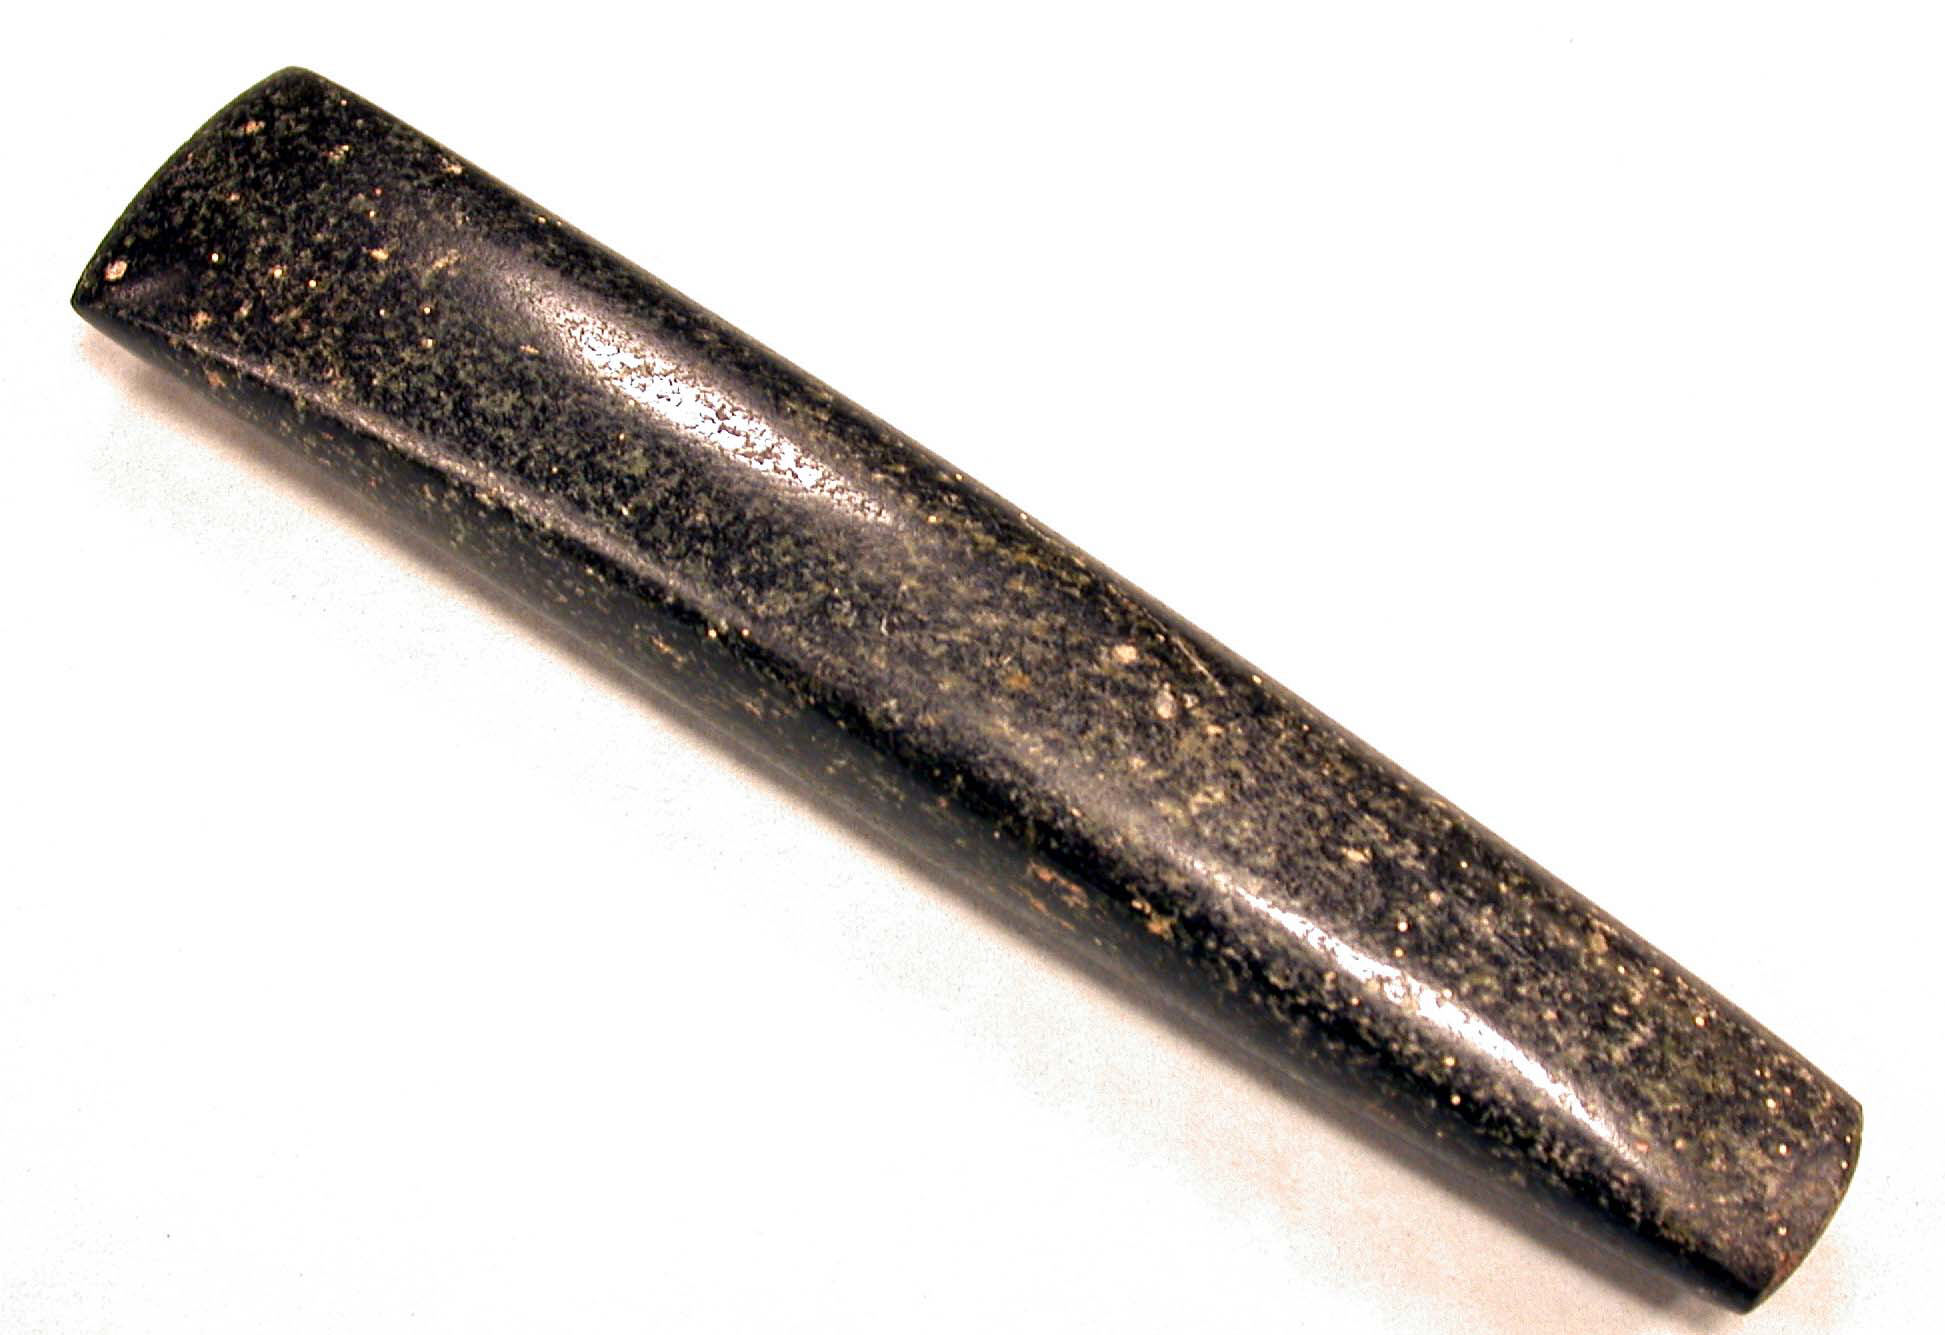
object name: chisel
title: Celt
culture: maya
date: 1501-1600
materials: stone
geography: guatemala